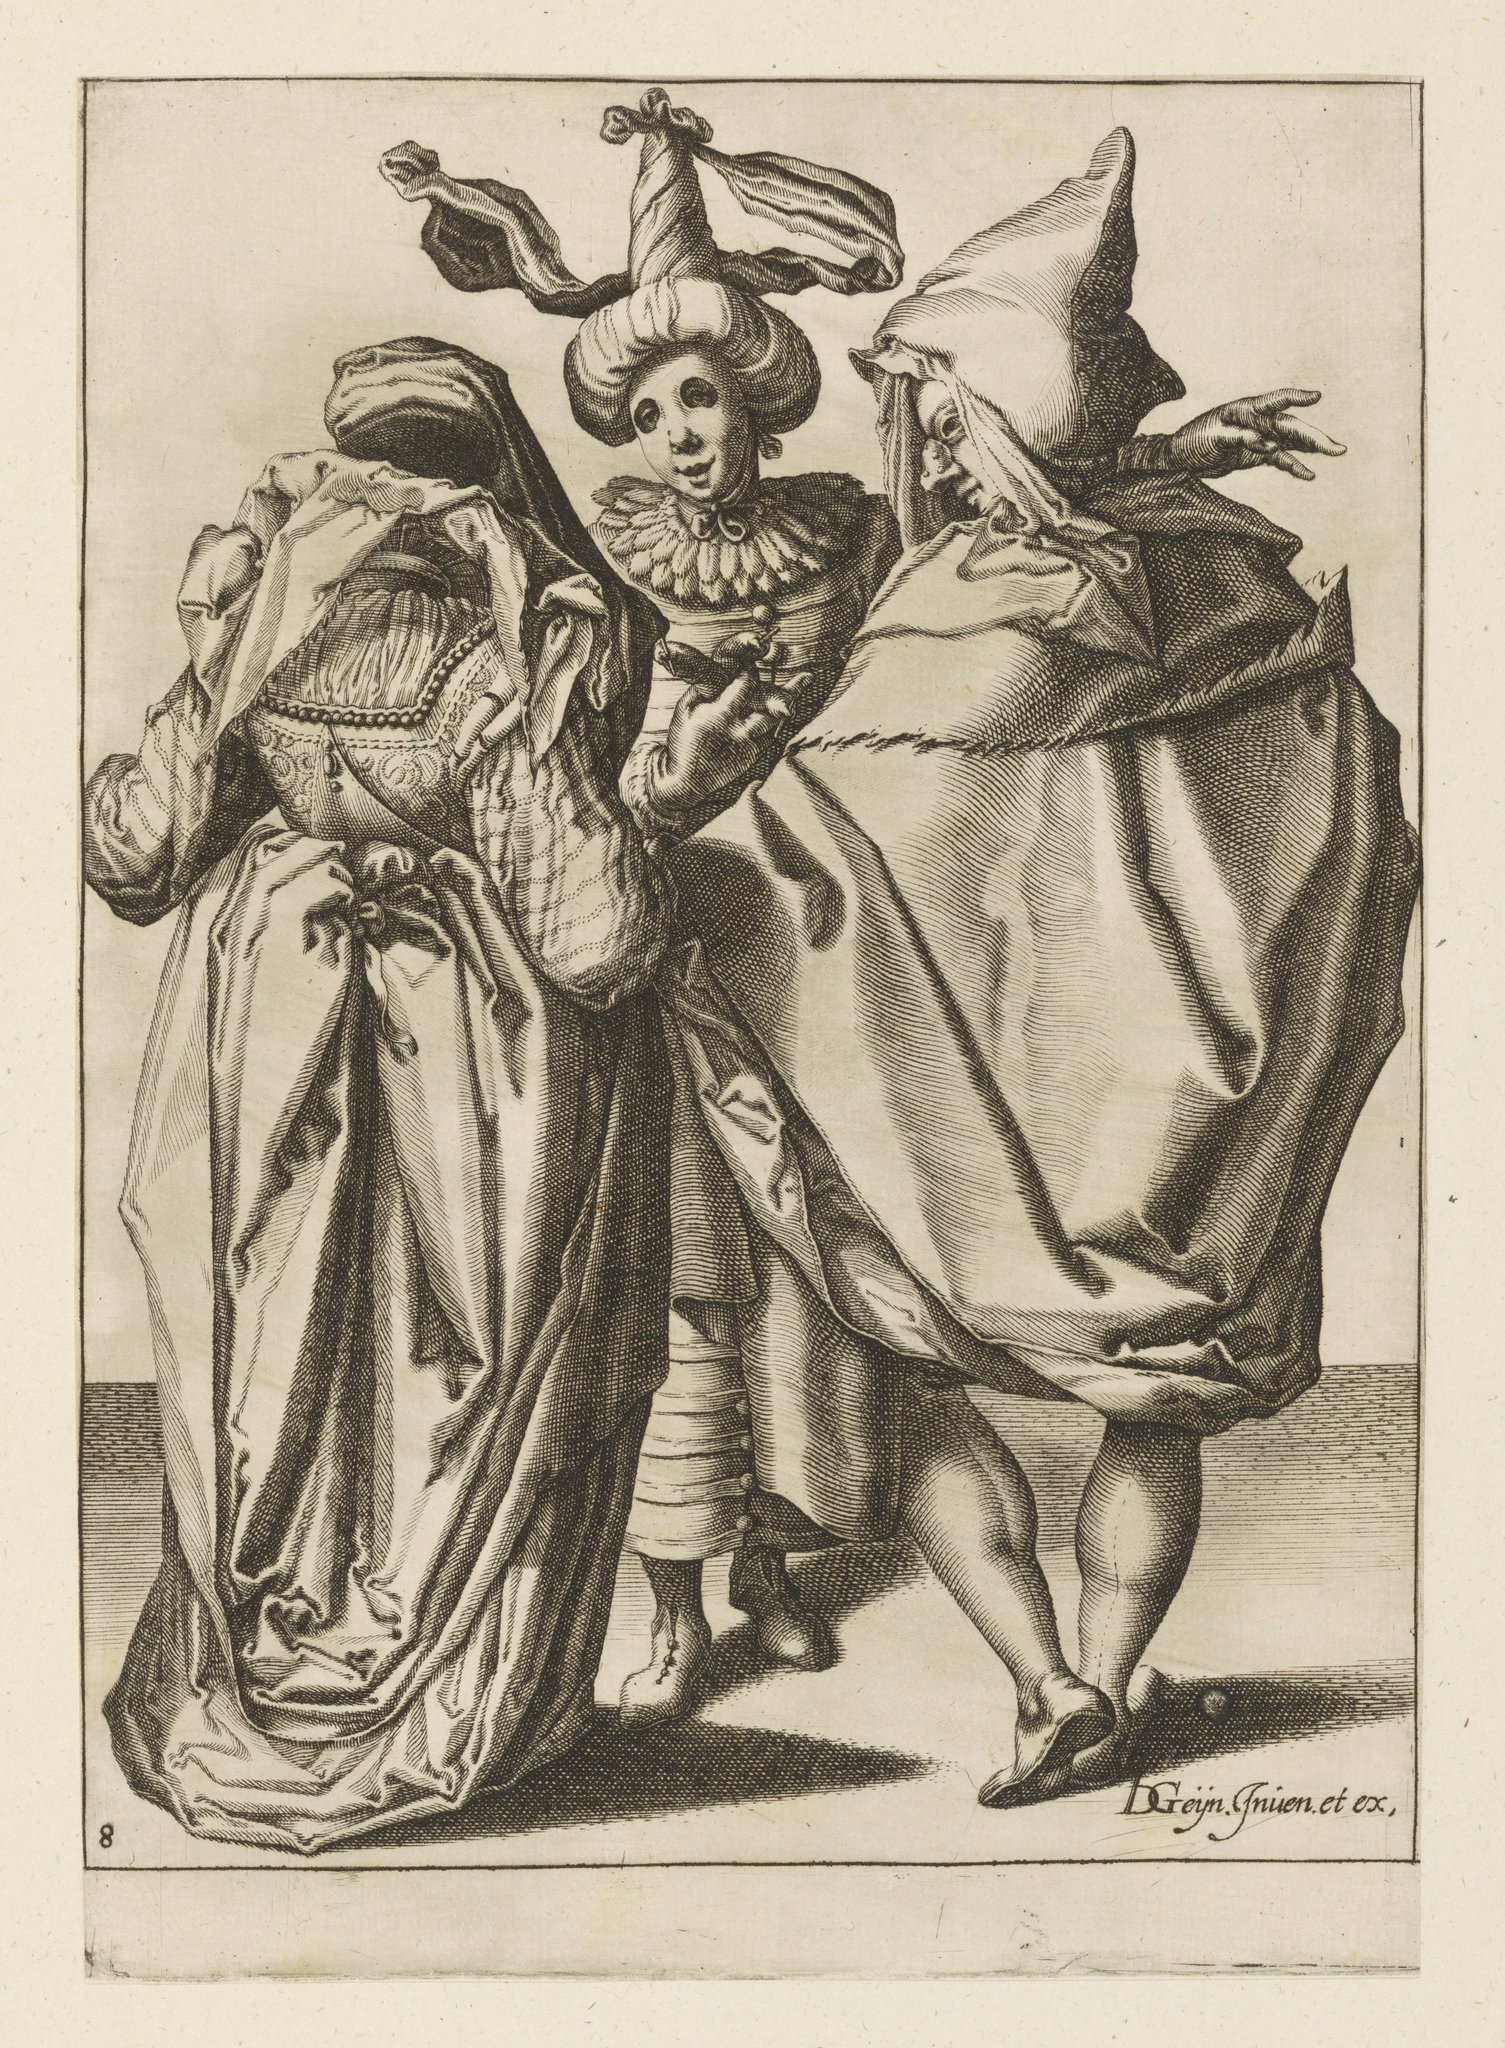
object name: print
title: A Couple Addressing a Gesticulating Young Man, plate 8 from "The Masquerades"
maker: jacques de gheyn (ii)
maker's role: artist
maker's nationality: netherlandish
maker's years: 1565-1629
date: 1595-1596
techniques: engraving